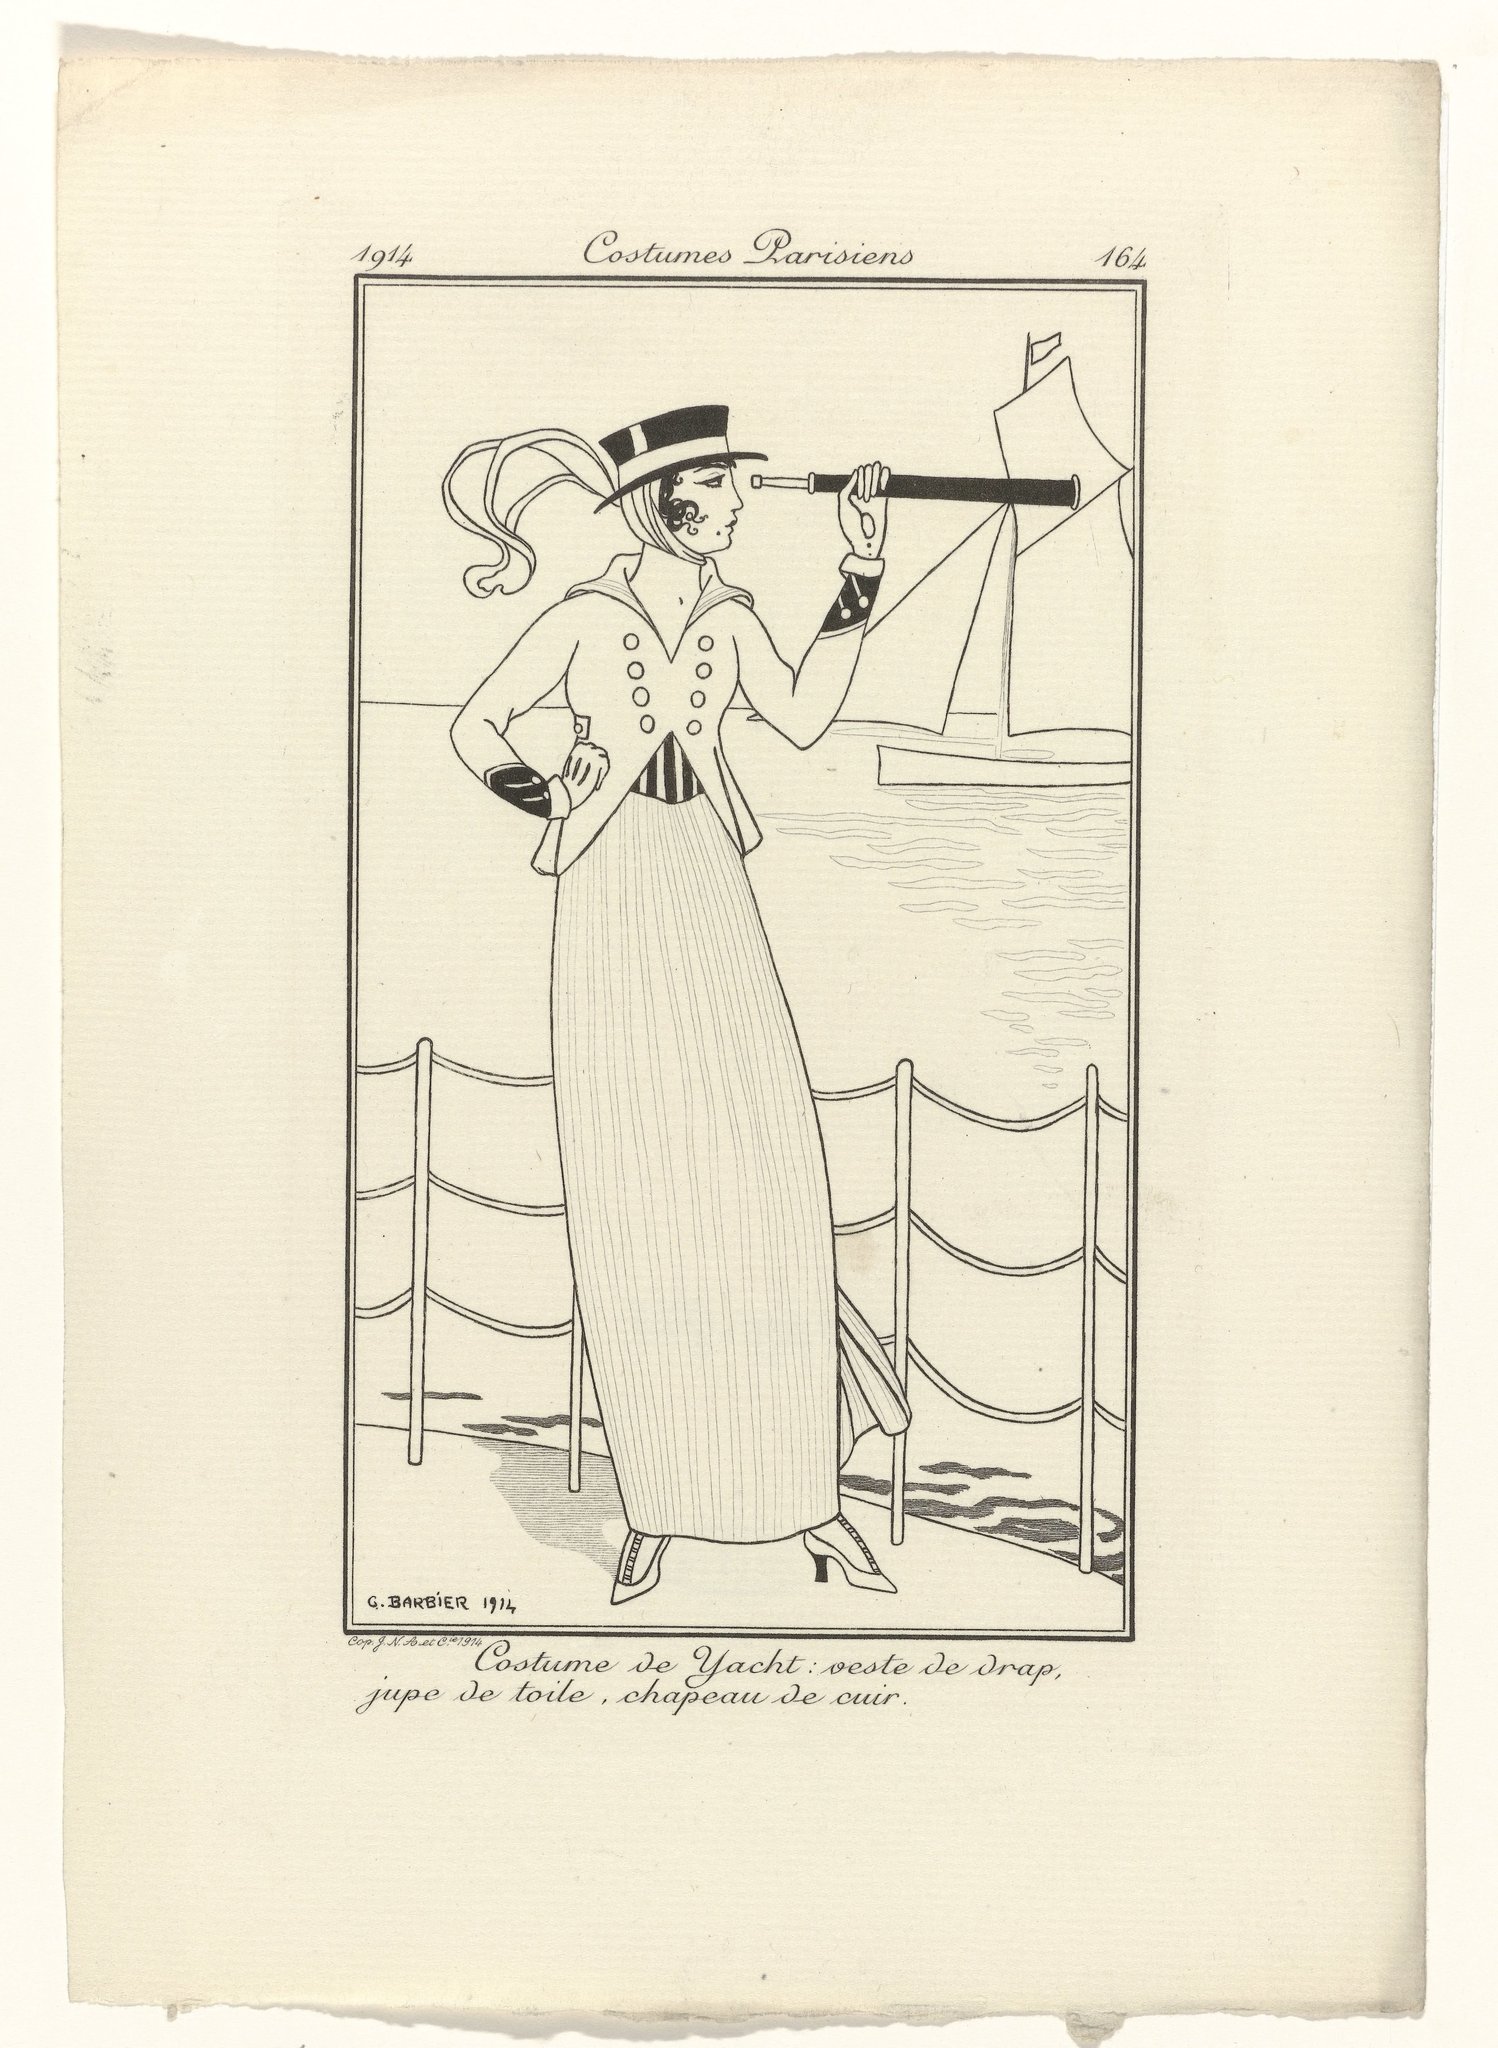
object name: fashion print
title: Journal des Dames et des Modes, Costumes Parisiens, 1914, No. 164 : Costume de Yacht (...)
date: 1914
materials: paper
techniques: engraving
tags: head-gear: hat (+ leather used for clothes), sailing (sport) (+ equipment, outfit (sports, games, etc.)), coat (+ women's clothes), fashion plates, head-gear: hat (+ women's clothes), skirt (+ women's clothes), binoculars, spy-glass, etc.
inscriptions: caption: ‘Costume de Yacht : veste de drap, jupe de toile, chapeau de cuir.’, inscription: ‘Cop. J. N. A. et Cie 1914’, title: ‘Costumes Parisiens’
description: Vrouw in een kostuum voor een pleziervaart: jasje van laken op een rok van gestreept doek. Hoed van leer. Verrekijker in de hand. Op de achtergrond een zeilschip. Proefdruk van een prent uit het modetijdschrift Journal des Dames et des Modes (1912-1914).